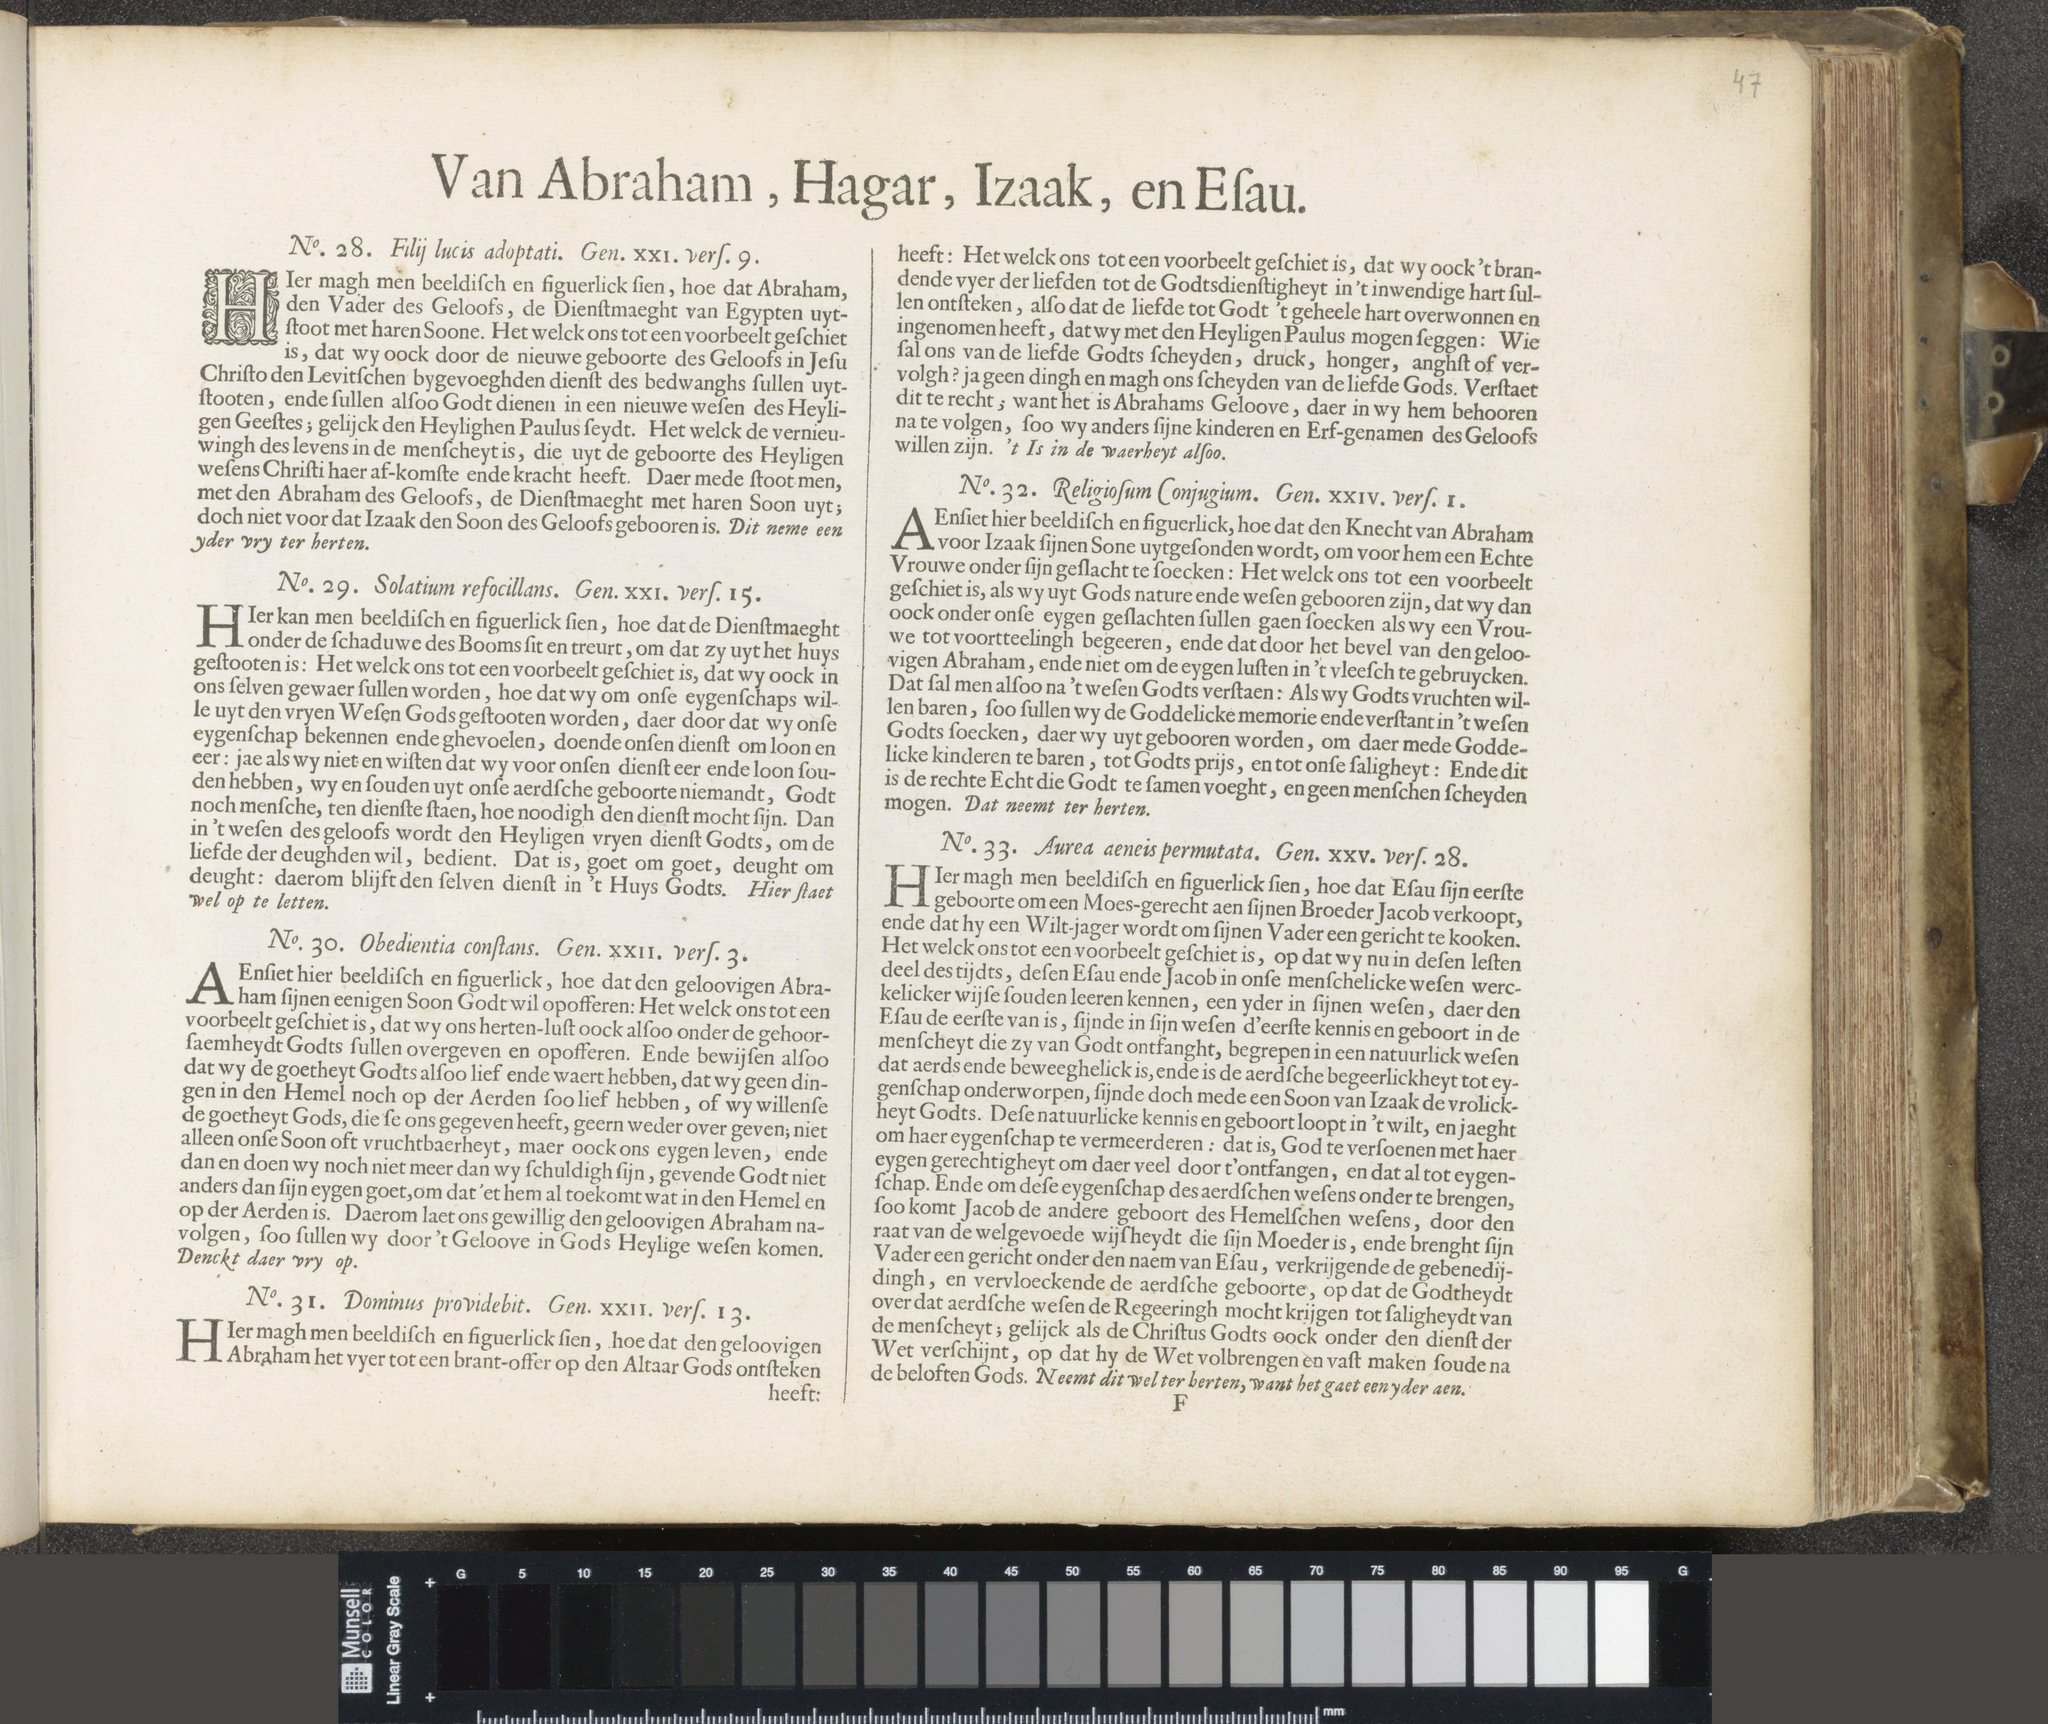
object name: album leaf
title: Zes toelichtingen bij voorstellingen over Abraham, Hagar, Isaak en Esau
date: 1653-1654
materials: paper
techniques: letterpress printing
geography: amsterdam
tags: initial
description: Zes toelichtingen bij voorstellingen over Abraham, Hagar, Isaak en Esau, genummerd 28 tot en met 33. De tekst vangt aan met een gedecoreerde initiaal H. Het blad maakt deel uit van een album.